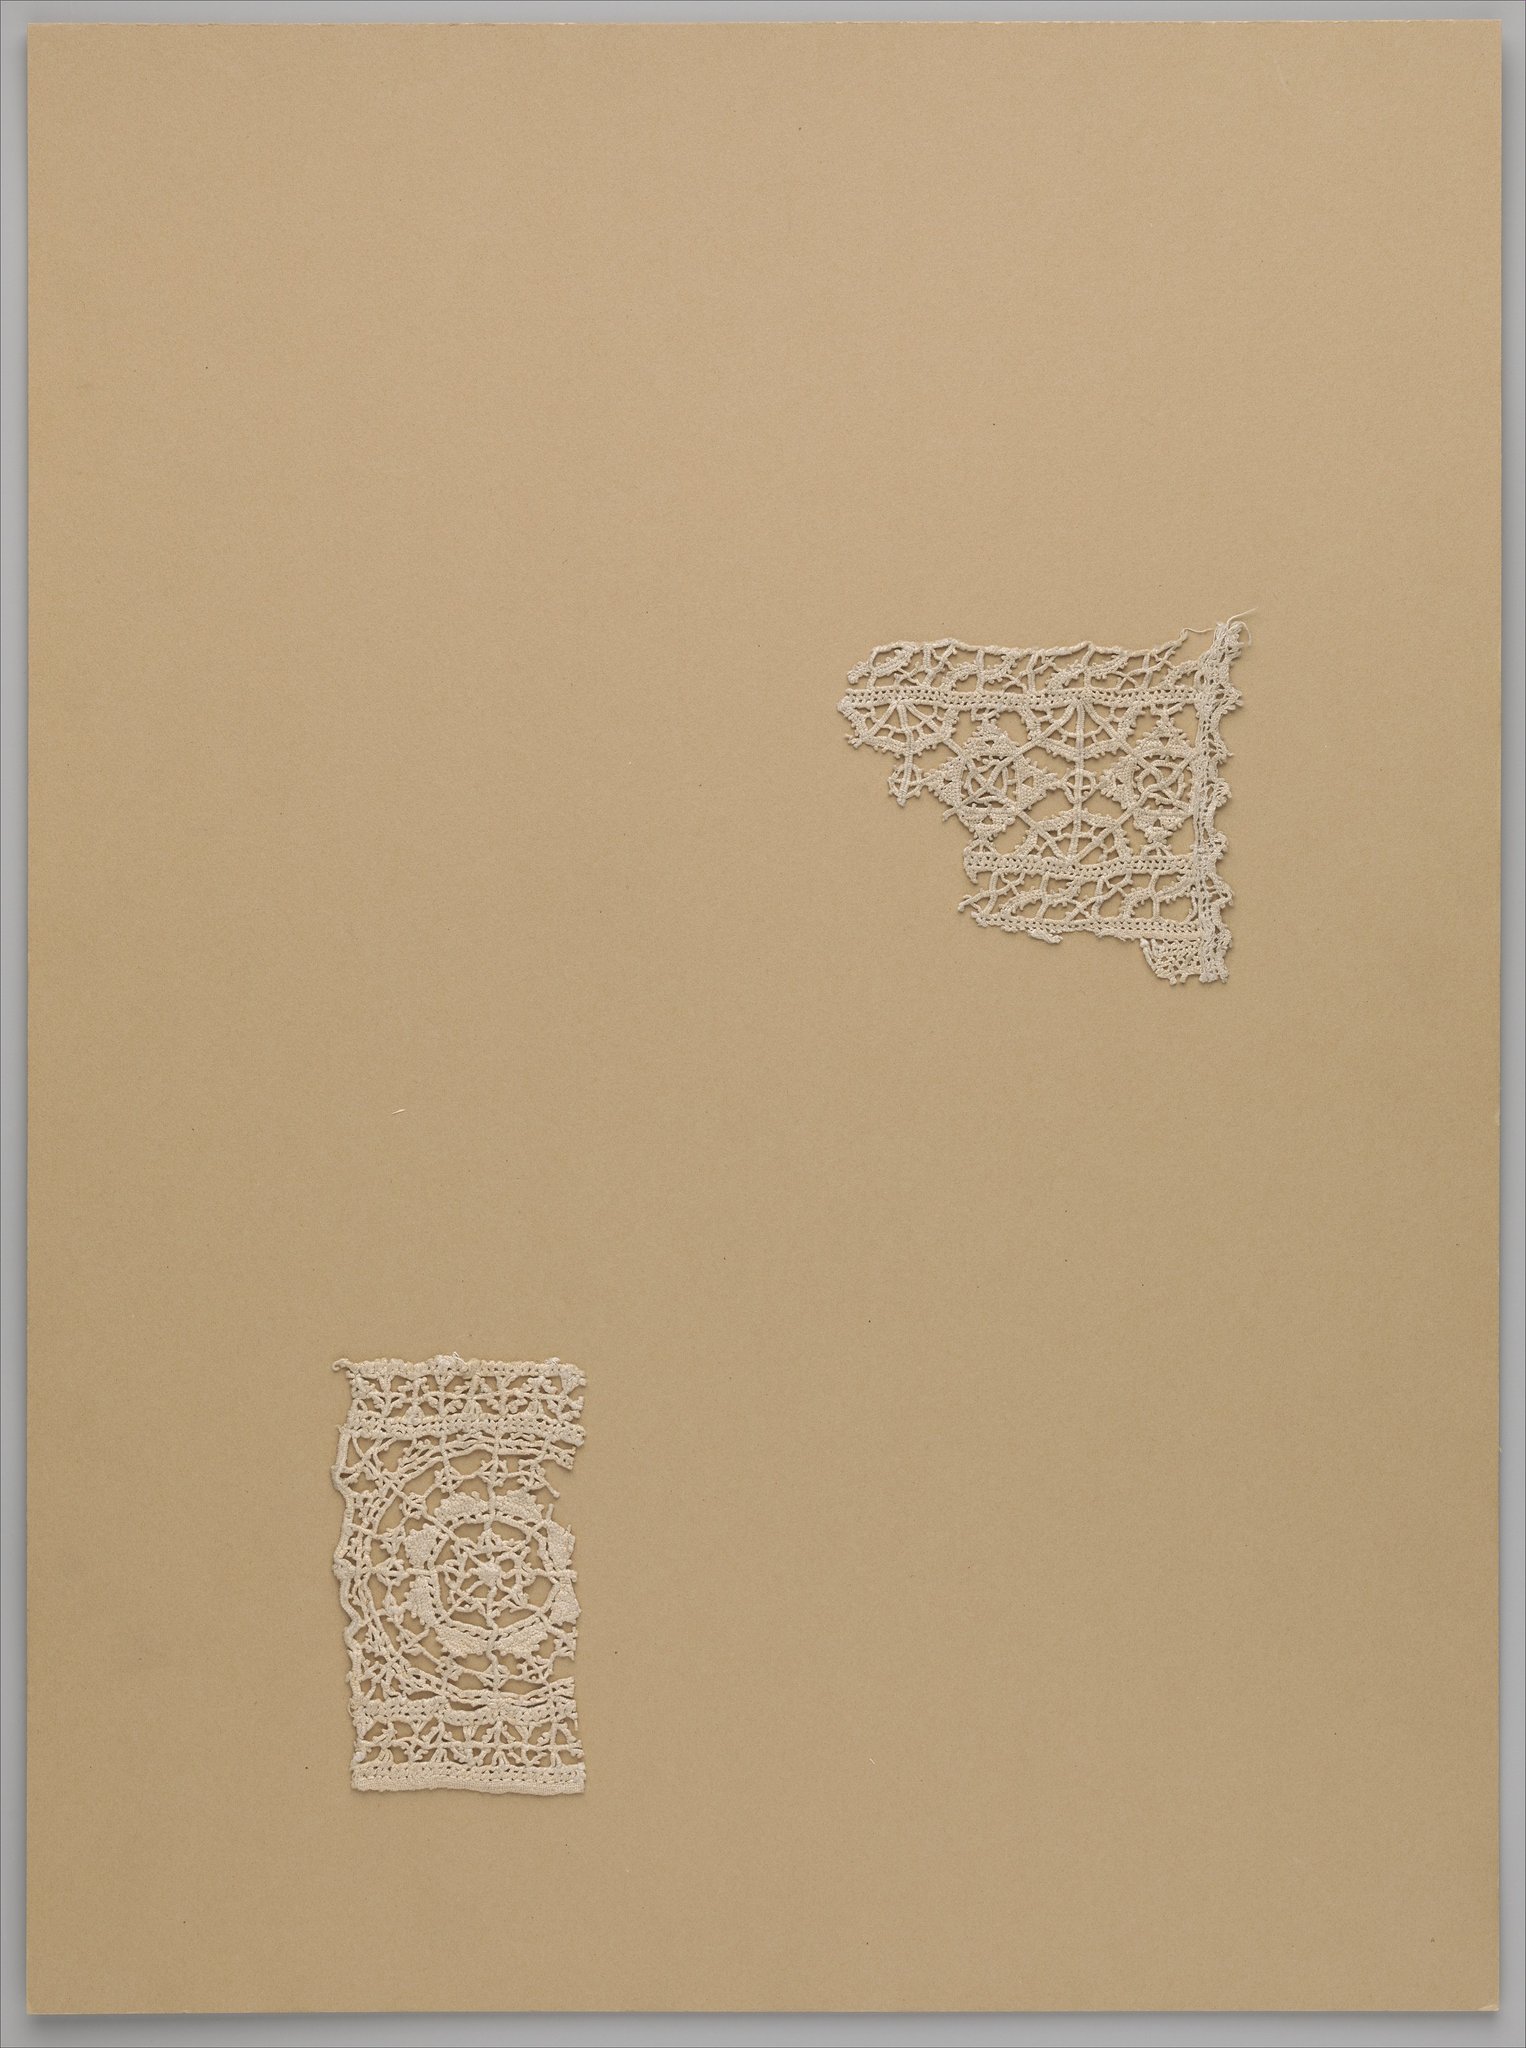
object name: piece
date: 1501-1700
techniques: embroidery